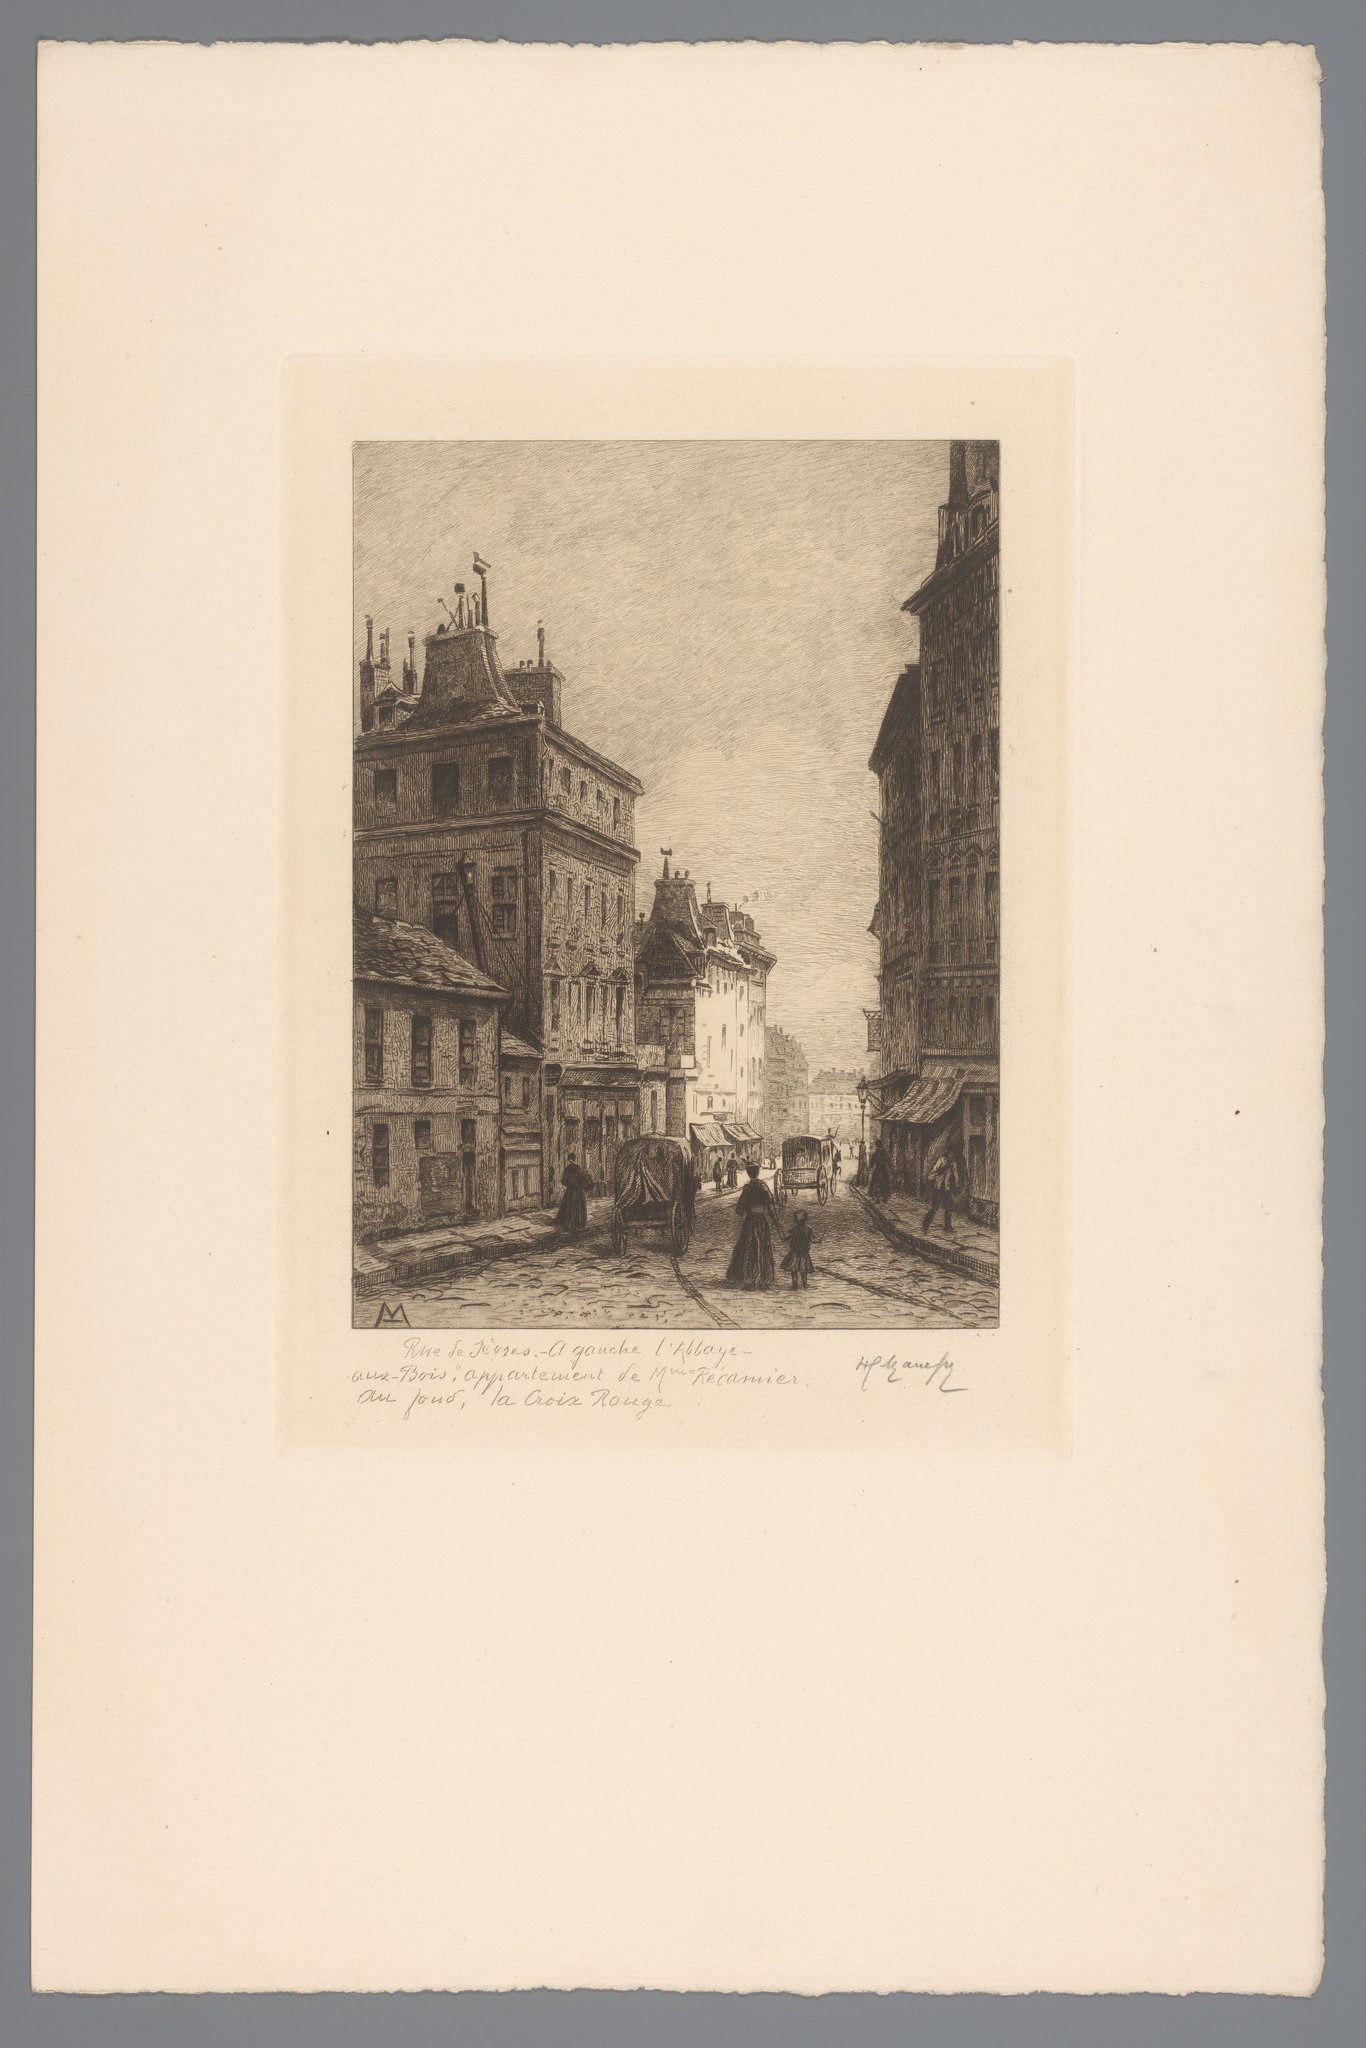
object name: print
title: Gezicht op de rue de Sèvres in Parijs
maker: henri manesse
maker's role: print maker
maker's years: 1854-1940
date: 1906-1911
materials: paper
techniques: drypoint, engraving, etching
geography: france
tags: covered wagon, hooded wagon, street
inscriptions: collector's mark: Lugt 2228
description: Dit is de eerste serie uit een prentreeks die uit minstens elf series bestaat.